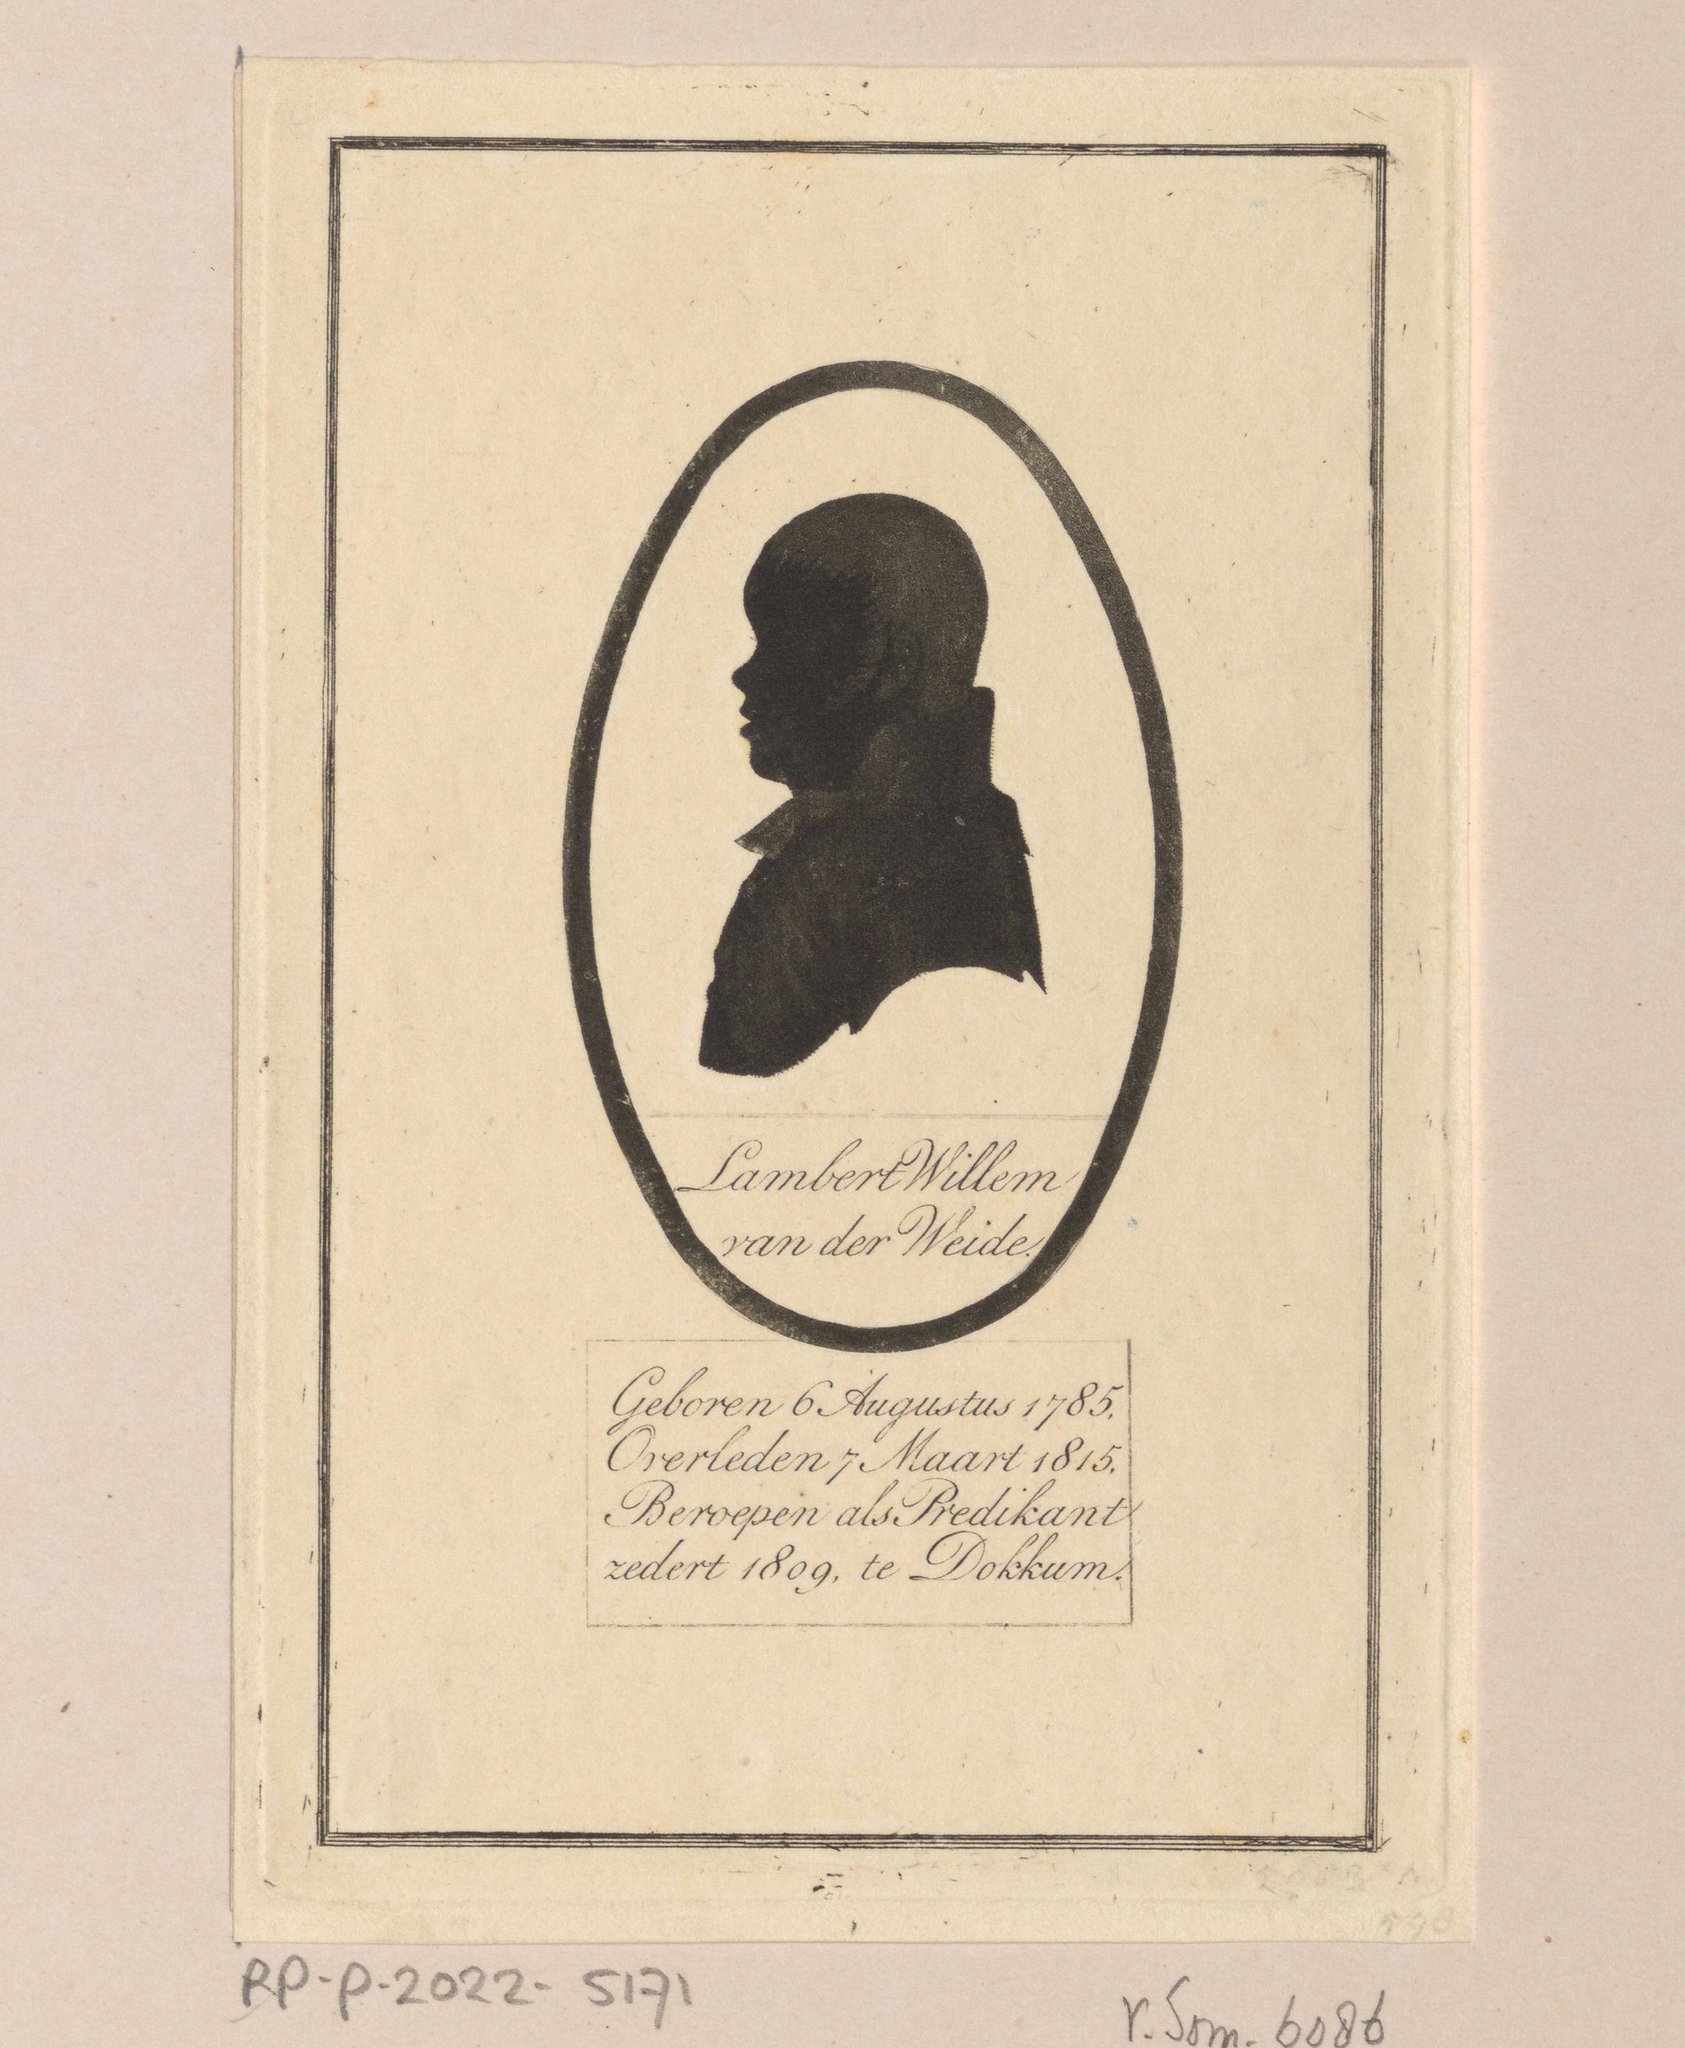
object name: print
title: Silhouetportret van Lambert Willem van der Weide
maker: Anonymous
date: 1815-1891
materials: paper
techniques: engraving, etching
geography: netherlands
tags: functionaries and dignitaries (with name) ~ protestant churches, historical persons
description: Met vierregelig onderschrift in het Nederlands.